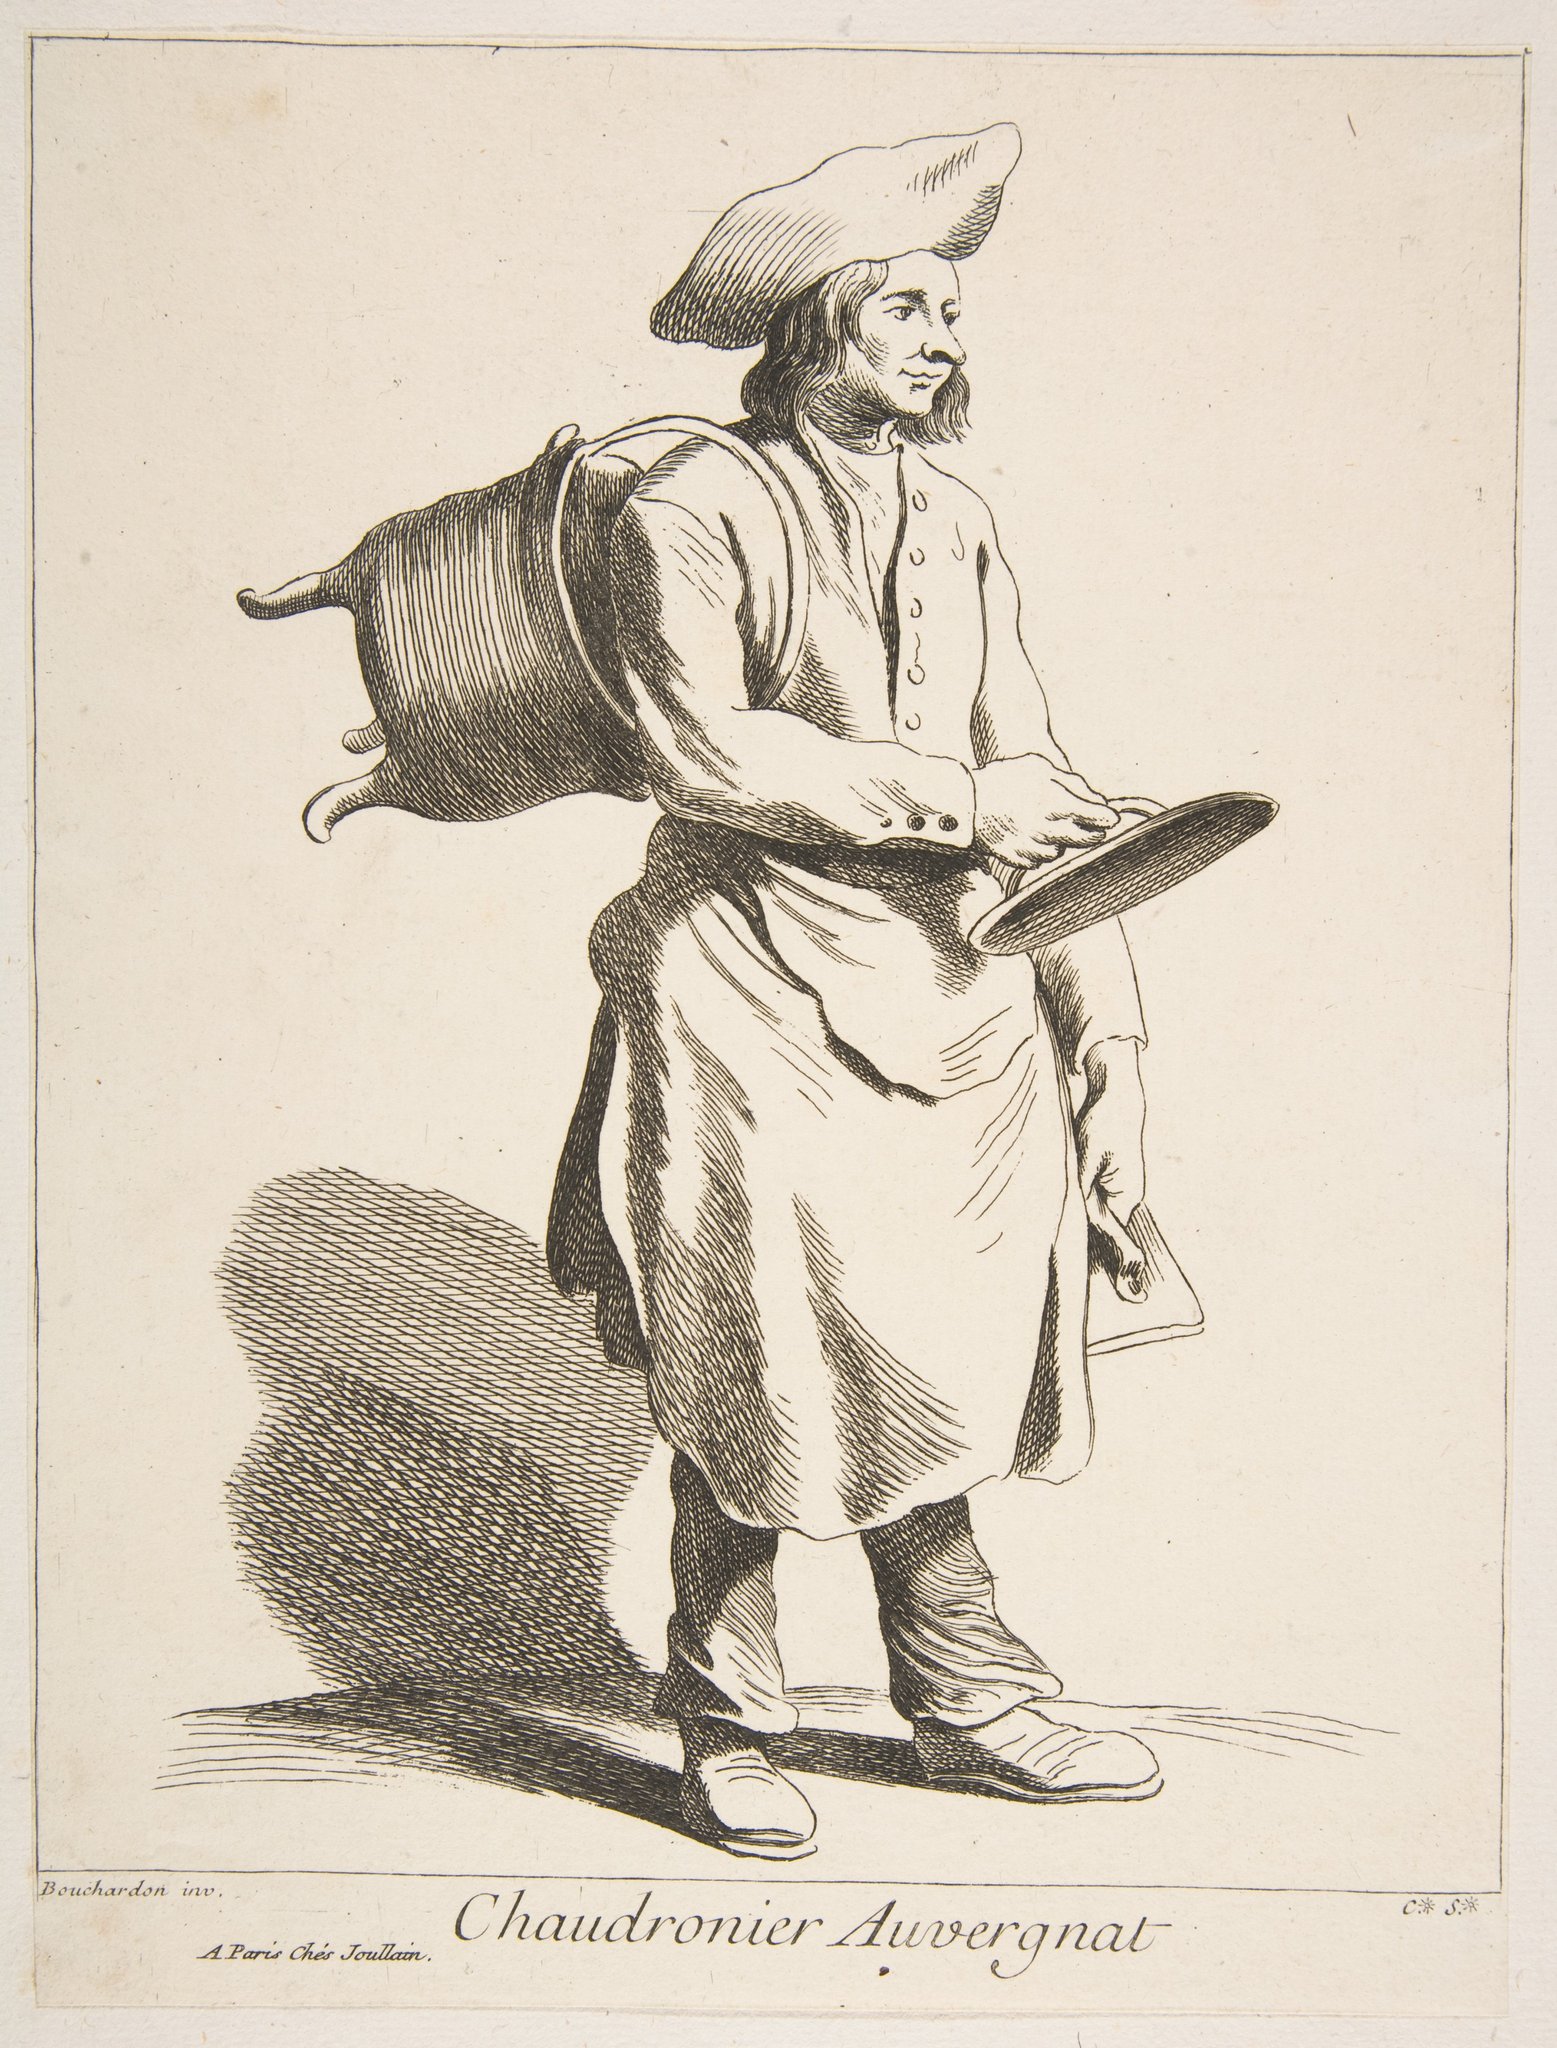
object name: print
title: Coppersmith from Auvergne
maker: anne claude philippe de tubières, comte de caylus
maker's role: artist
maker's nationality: french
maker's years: 1692-1765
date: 1737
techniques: engraving, etching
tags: men